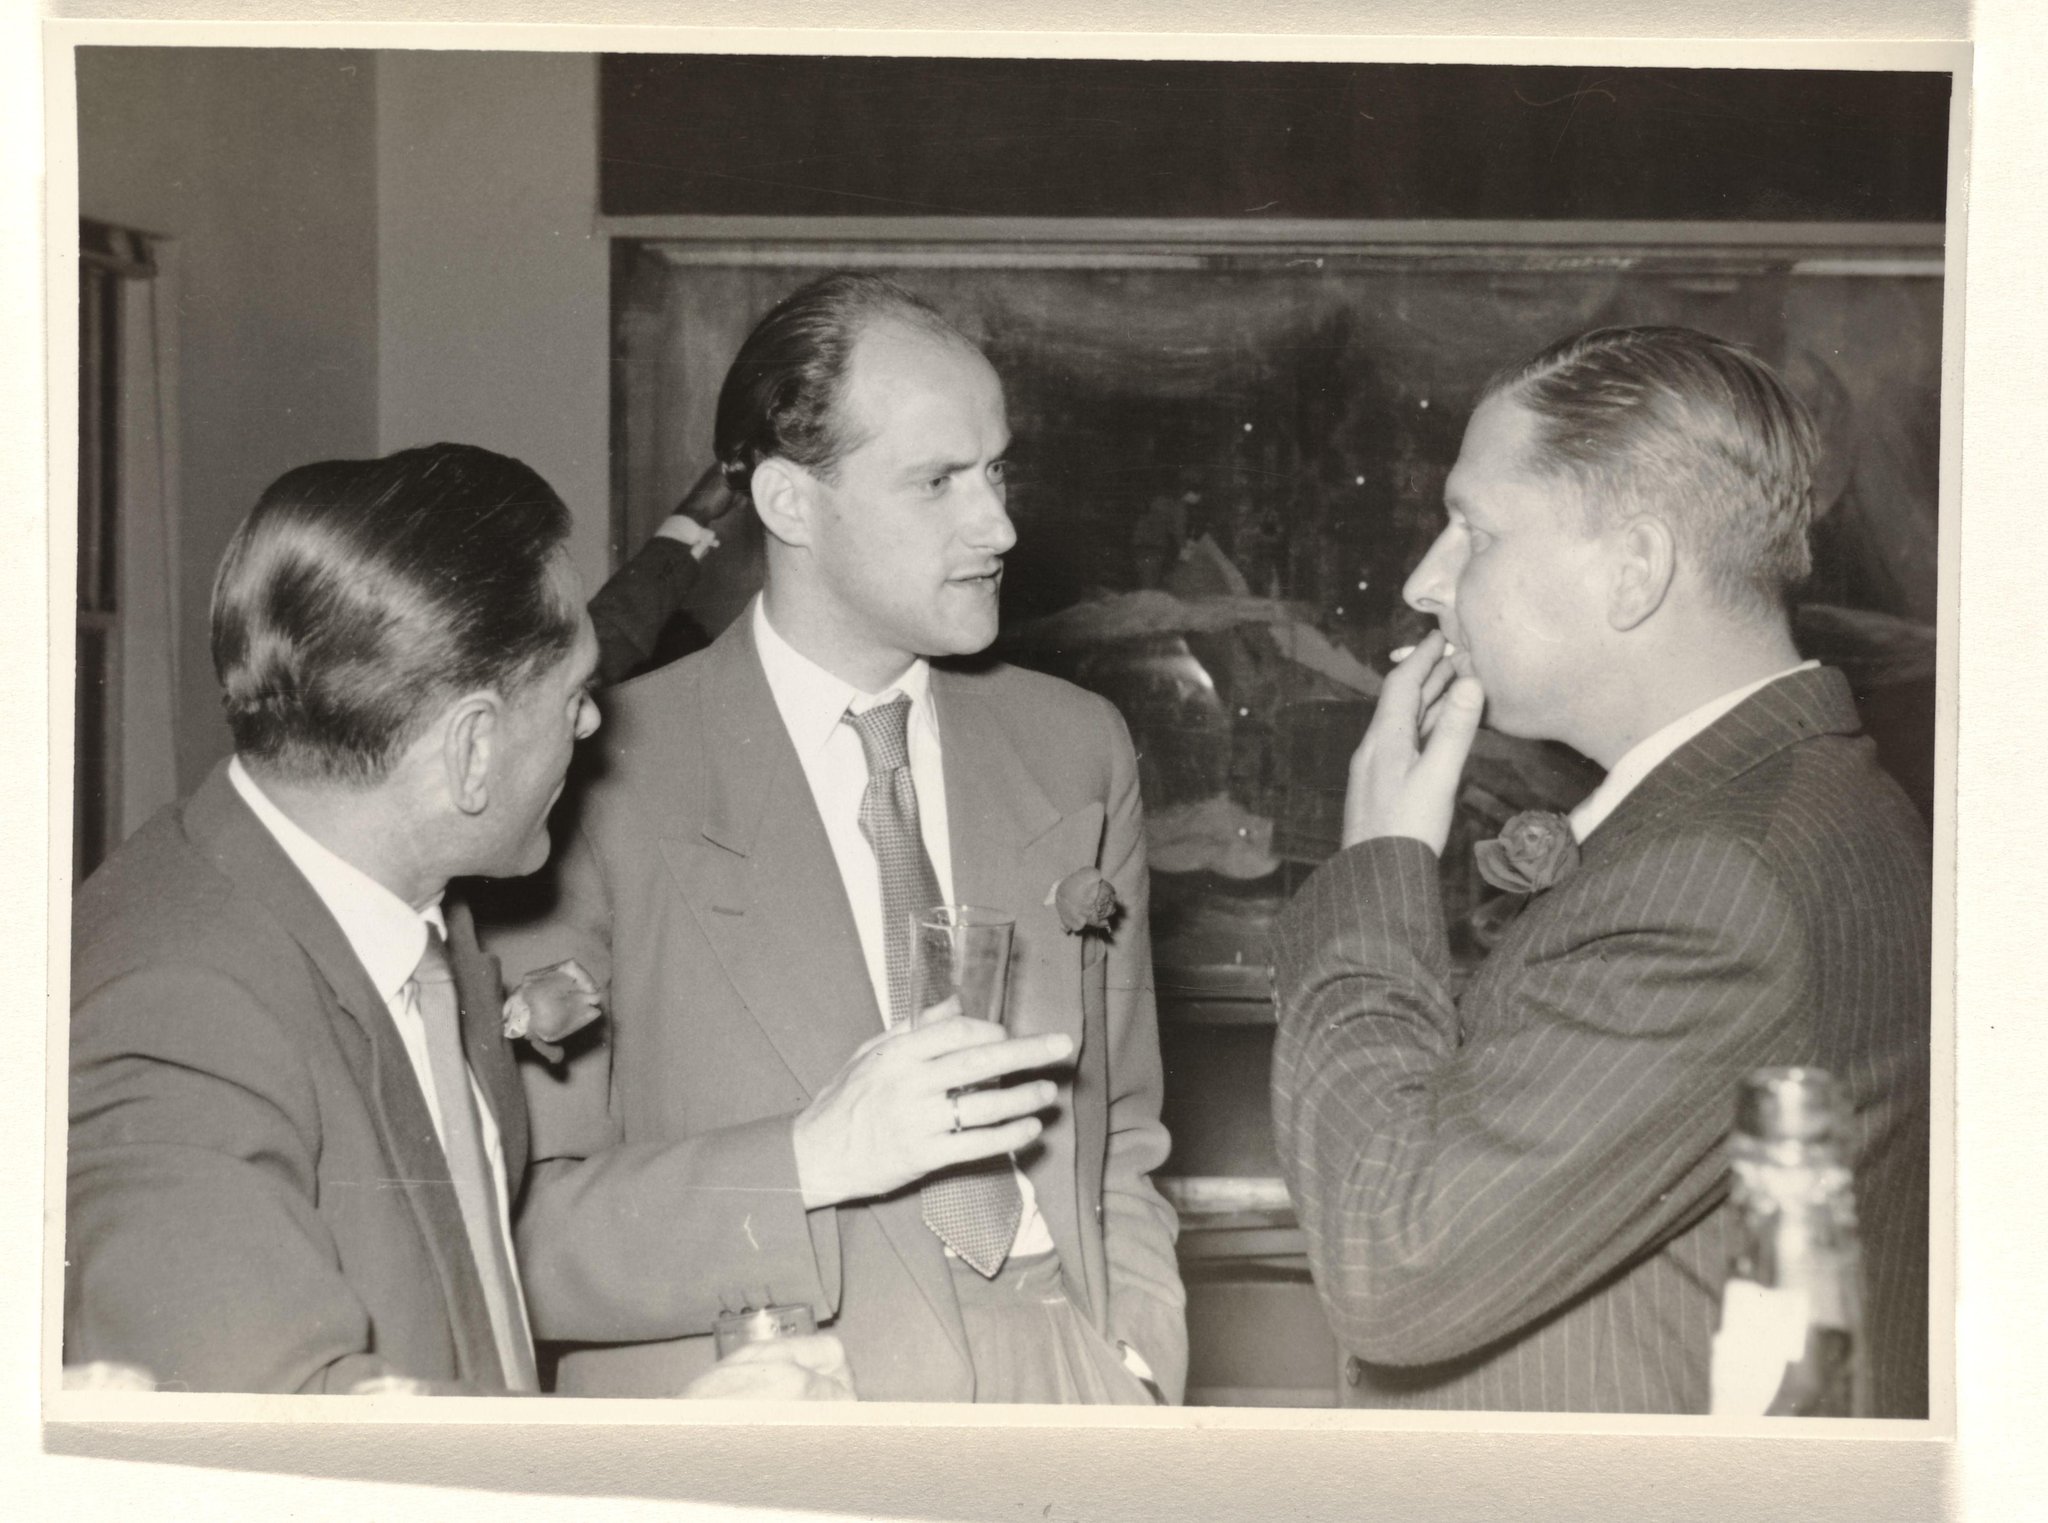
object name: photograph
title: Gideon Elon met bloem in zijn revers in gesprek met twee onbekende mannen, tijdens een receptie gedurende de KLM-tijd van Isabel Wachenheimer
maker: Anonymous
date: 1956-1973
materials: photographic support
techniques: gelatin silver print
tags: gideon elon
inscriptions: number: ‘2129/3’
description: Gideon Elon in gesprek met twee onbekende mannen, tijdens een receptie.